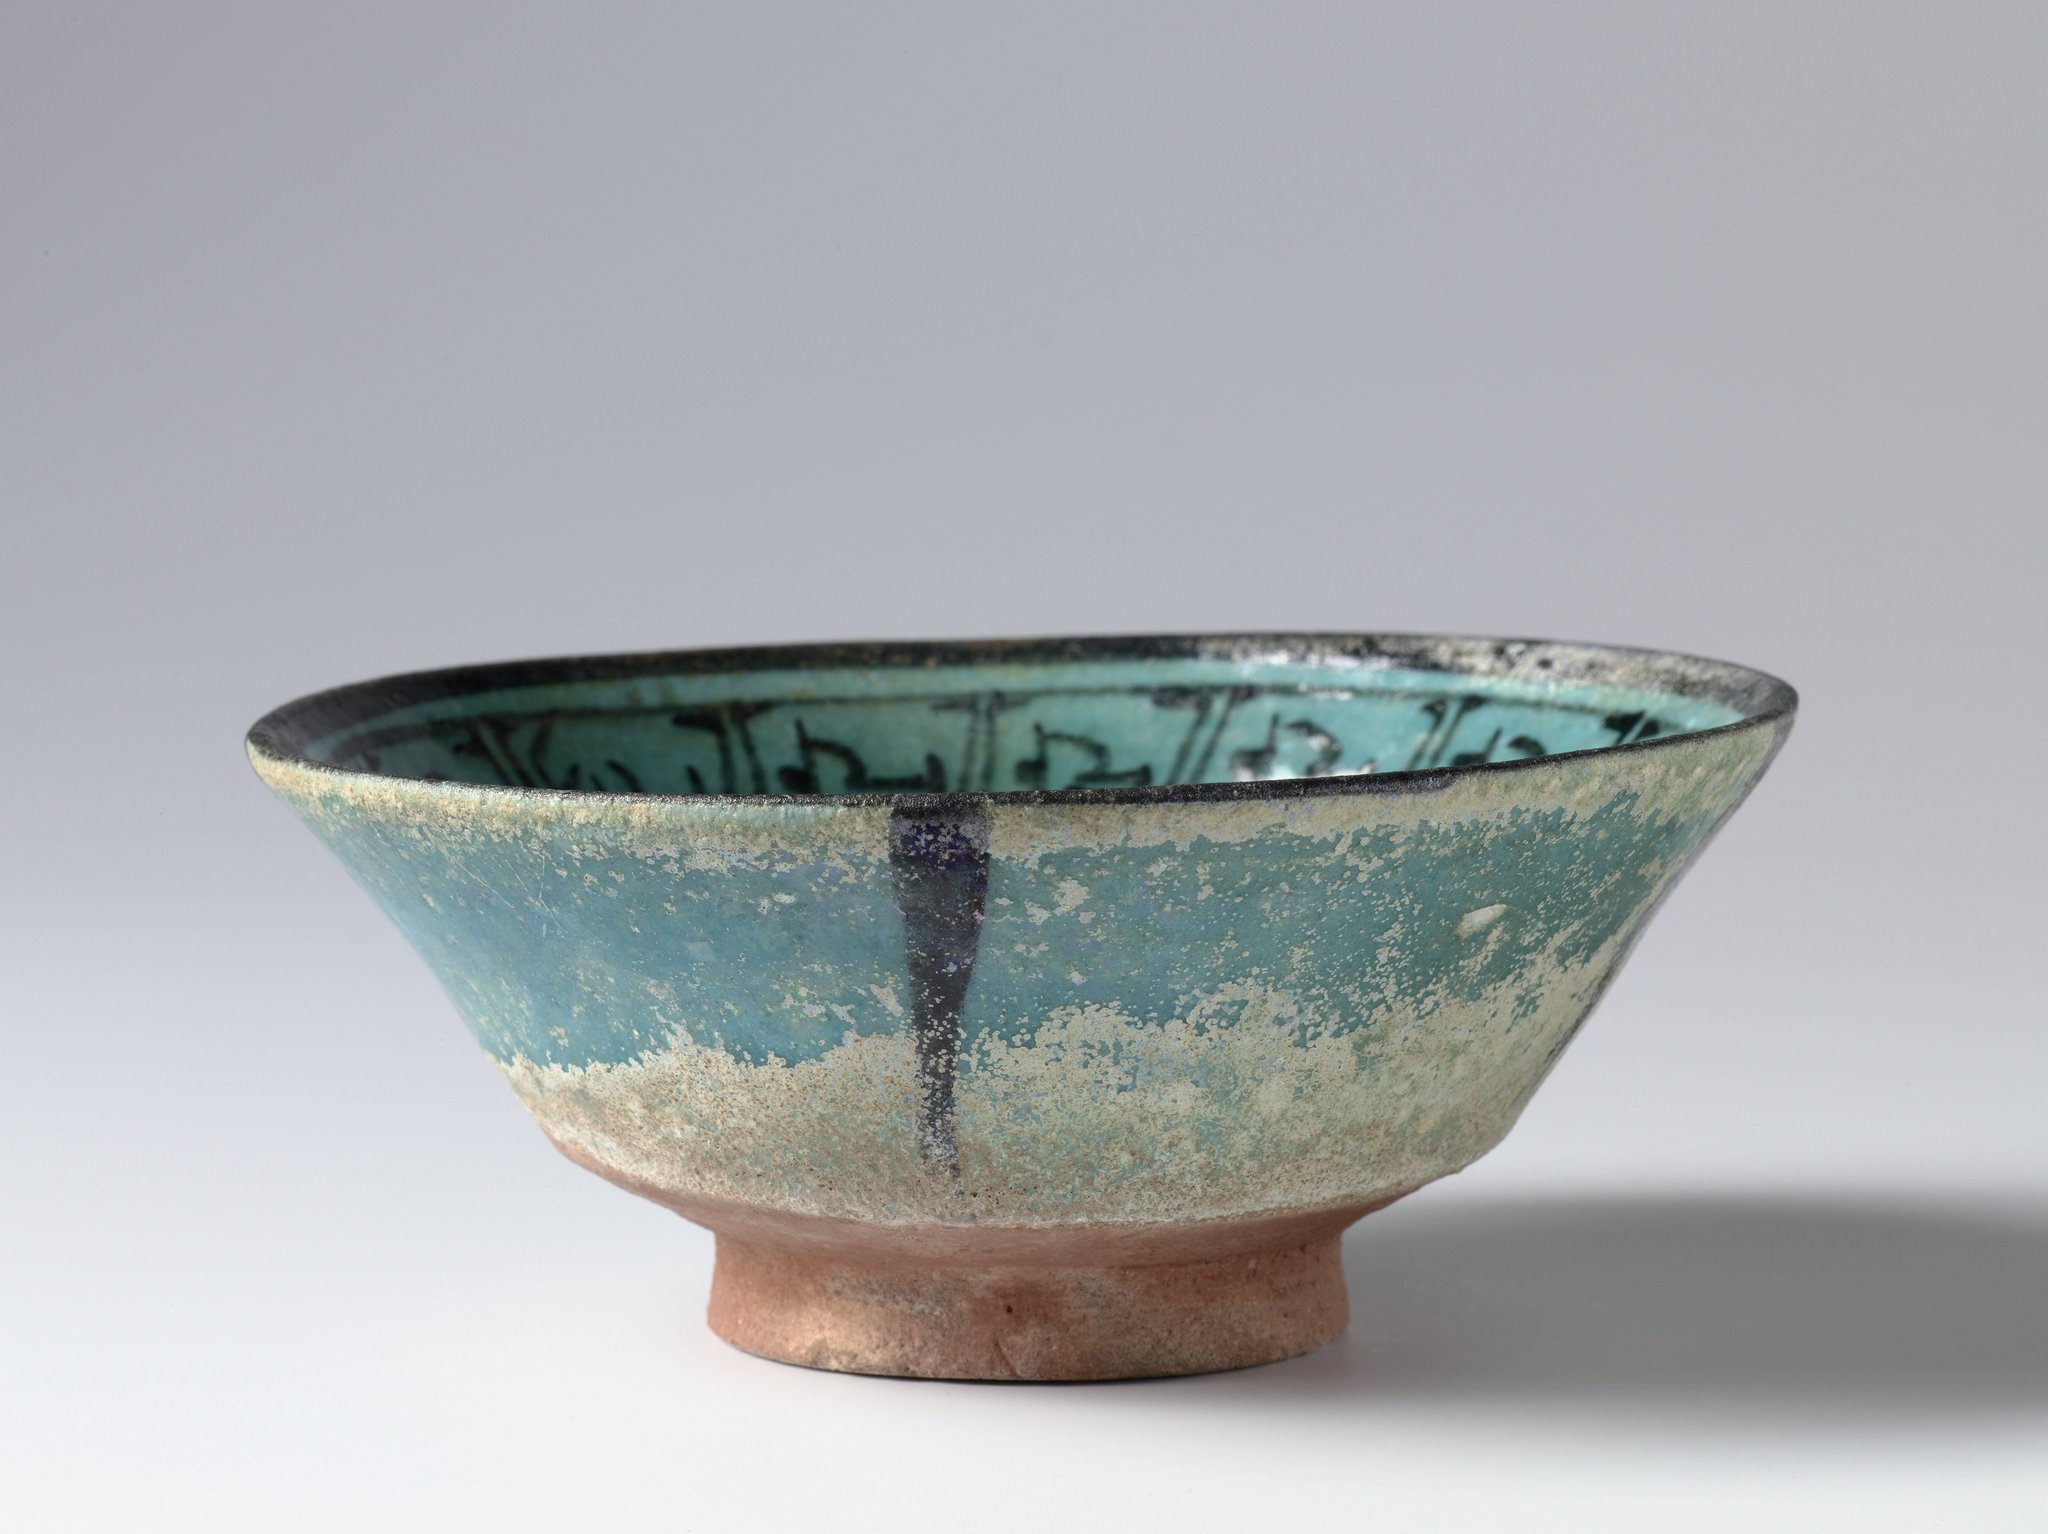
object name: bowl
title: Bowl with a stylized plant and a border with a pseudo-inscription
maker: Anonymous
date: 1200-1299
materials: earthenware, glaze, paint, quartz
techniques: firing, turning, vitrification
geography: gorgan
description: Kom van kwarts-fritgoed met een beschildering in zwart met een gestileerde plant en een band met pseudo-schrift onder een transparant turquoise alkaliglazuur.